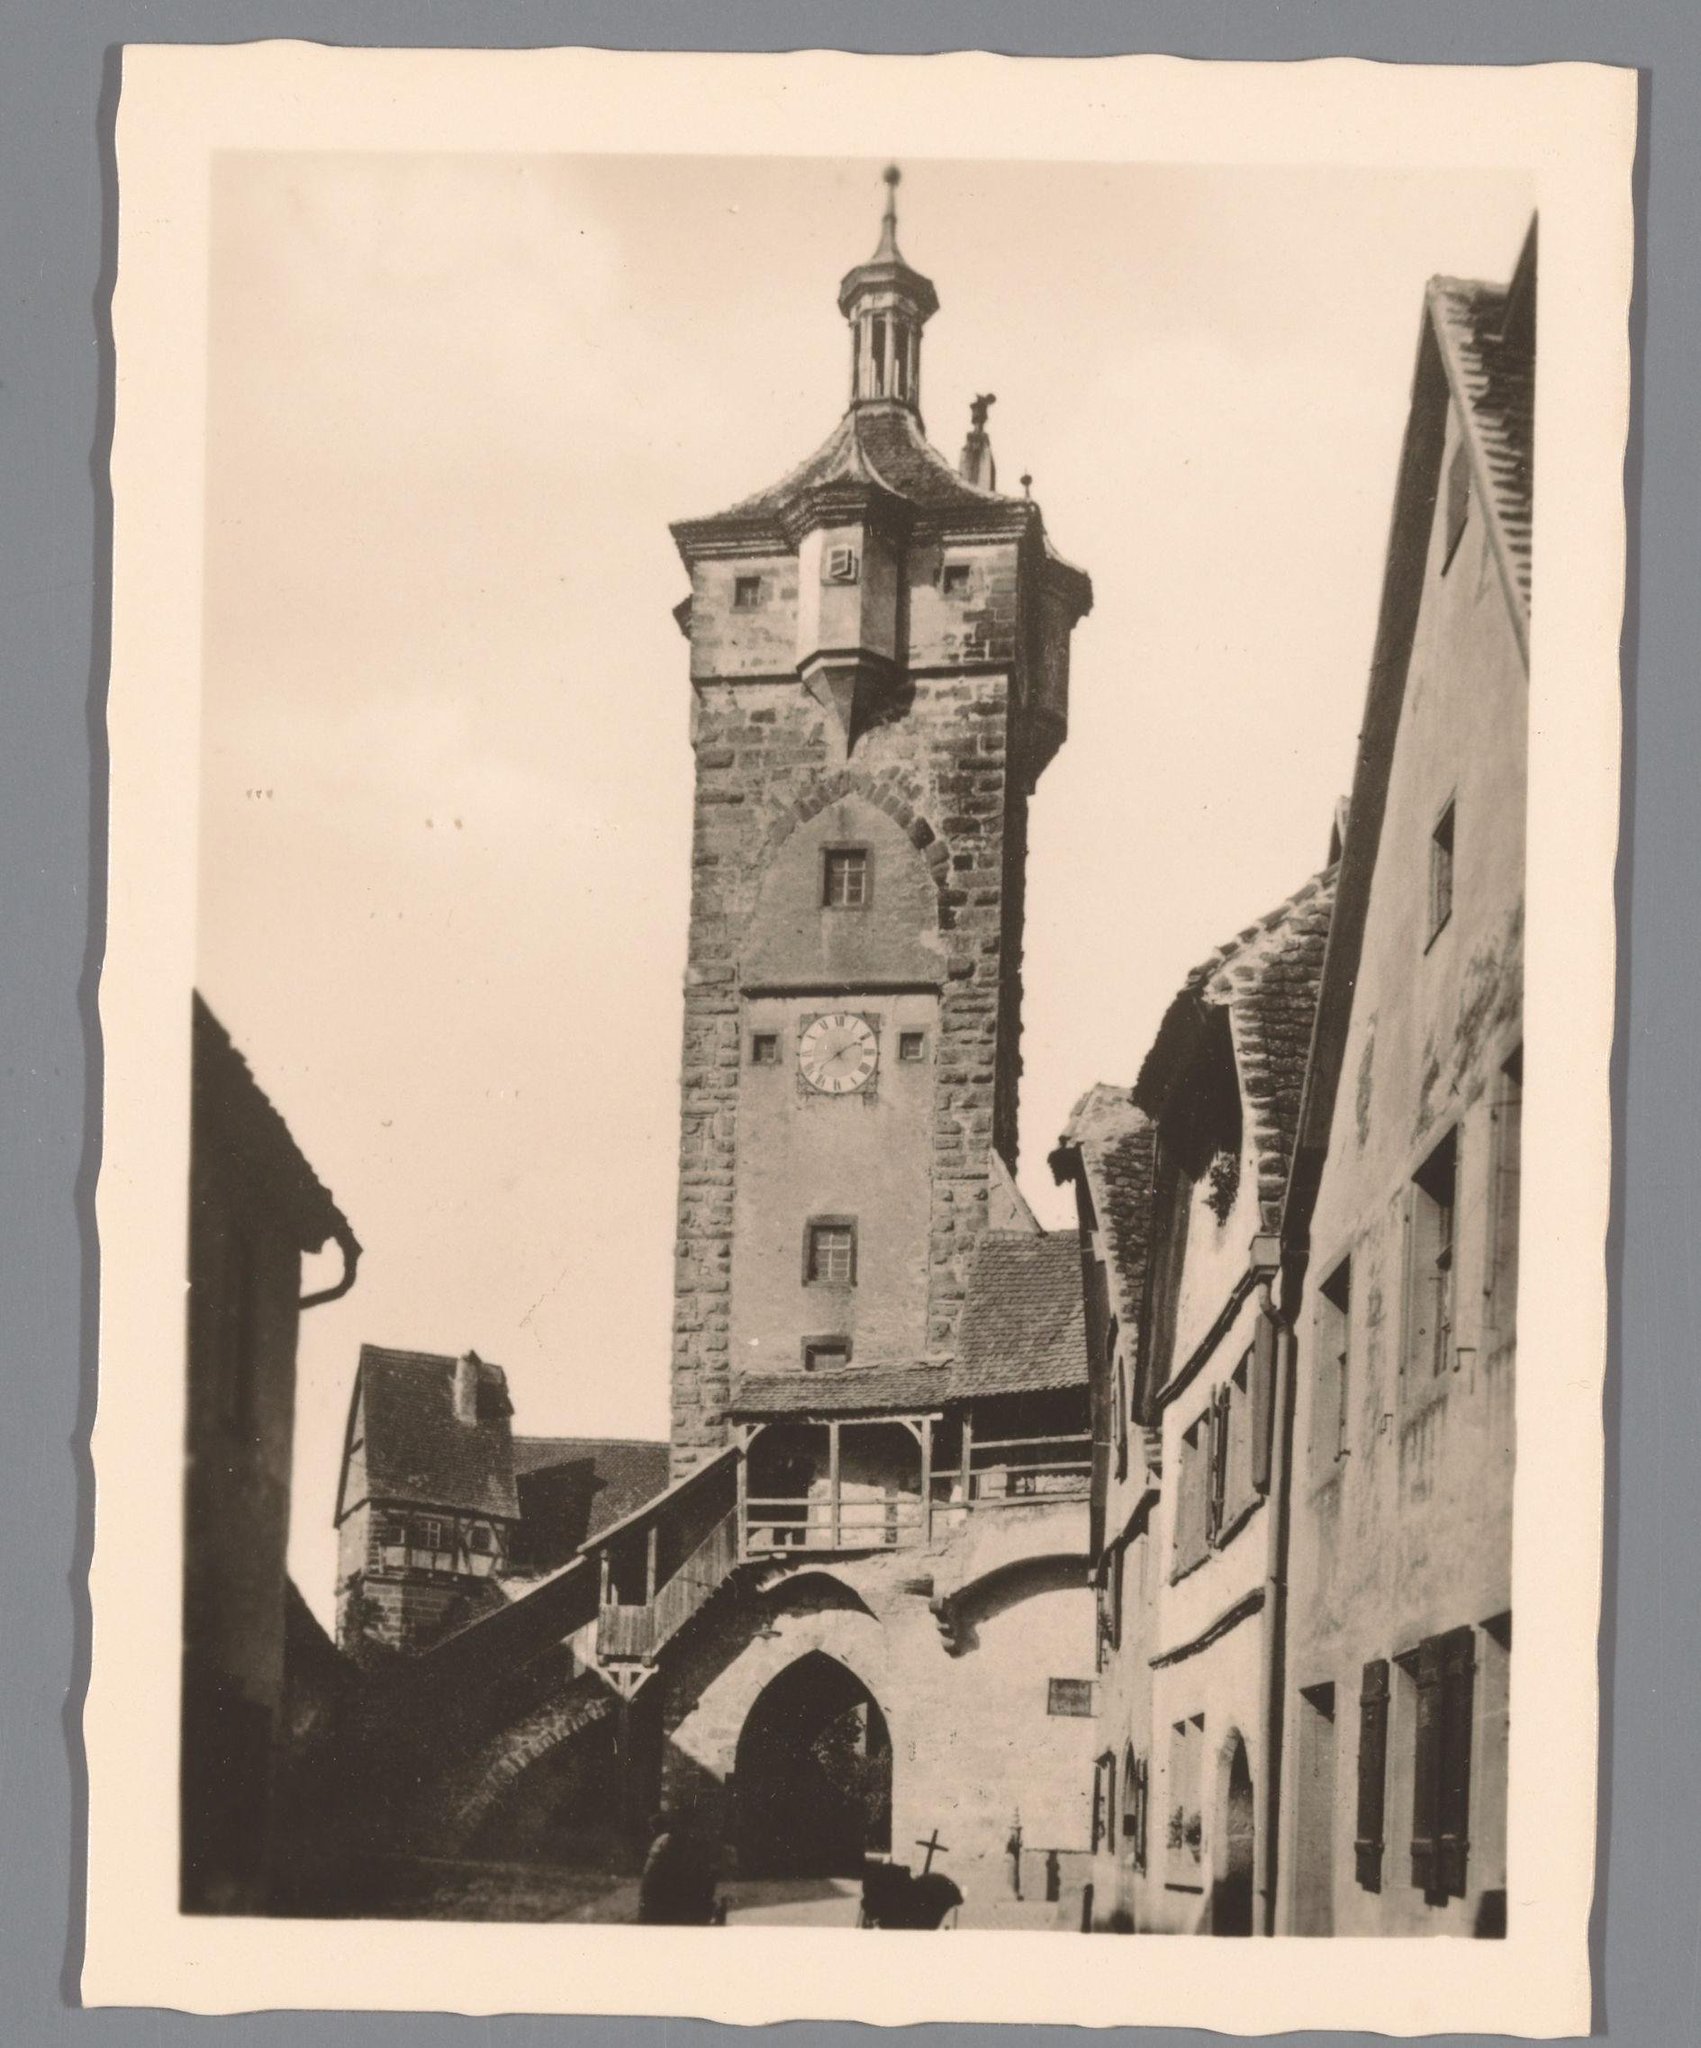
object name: photograph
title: Gezicht op de Klingentor in Rothenburg ob der Tauber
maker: Anonymous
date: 1940-1960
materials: photographic support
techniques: gelatin silver print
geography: rothenburg ob der tauber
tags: tower, clock tower ~ monumental adornment